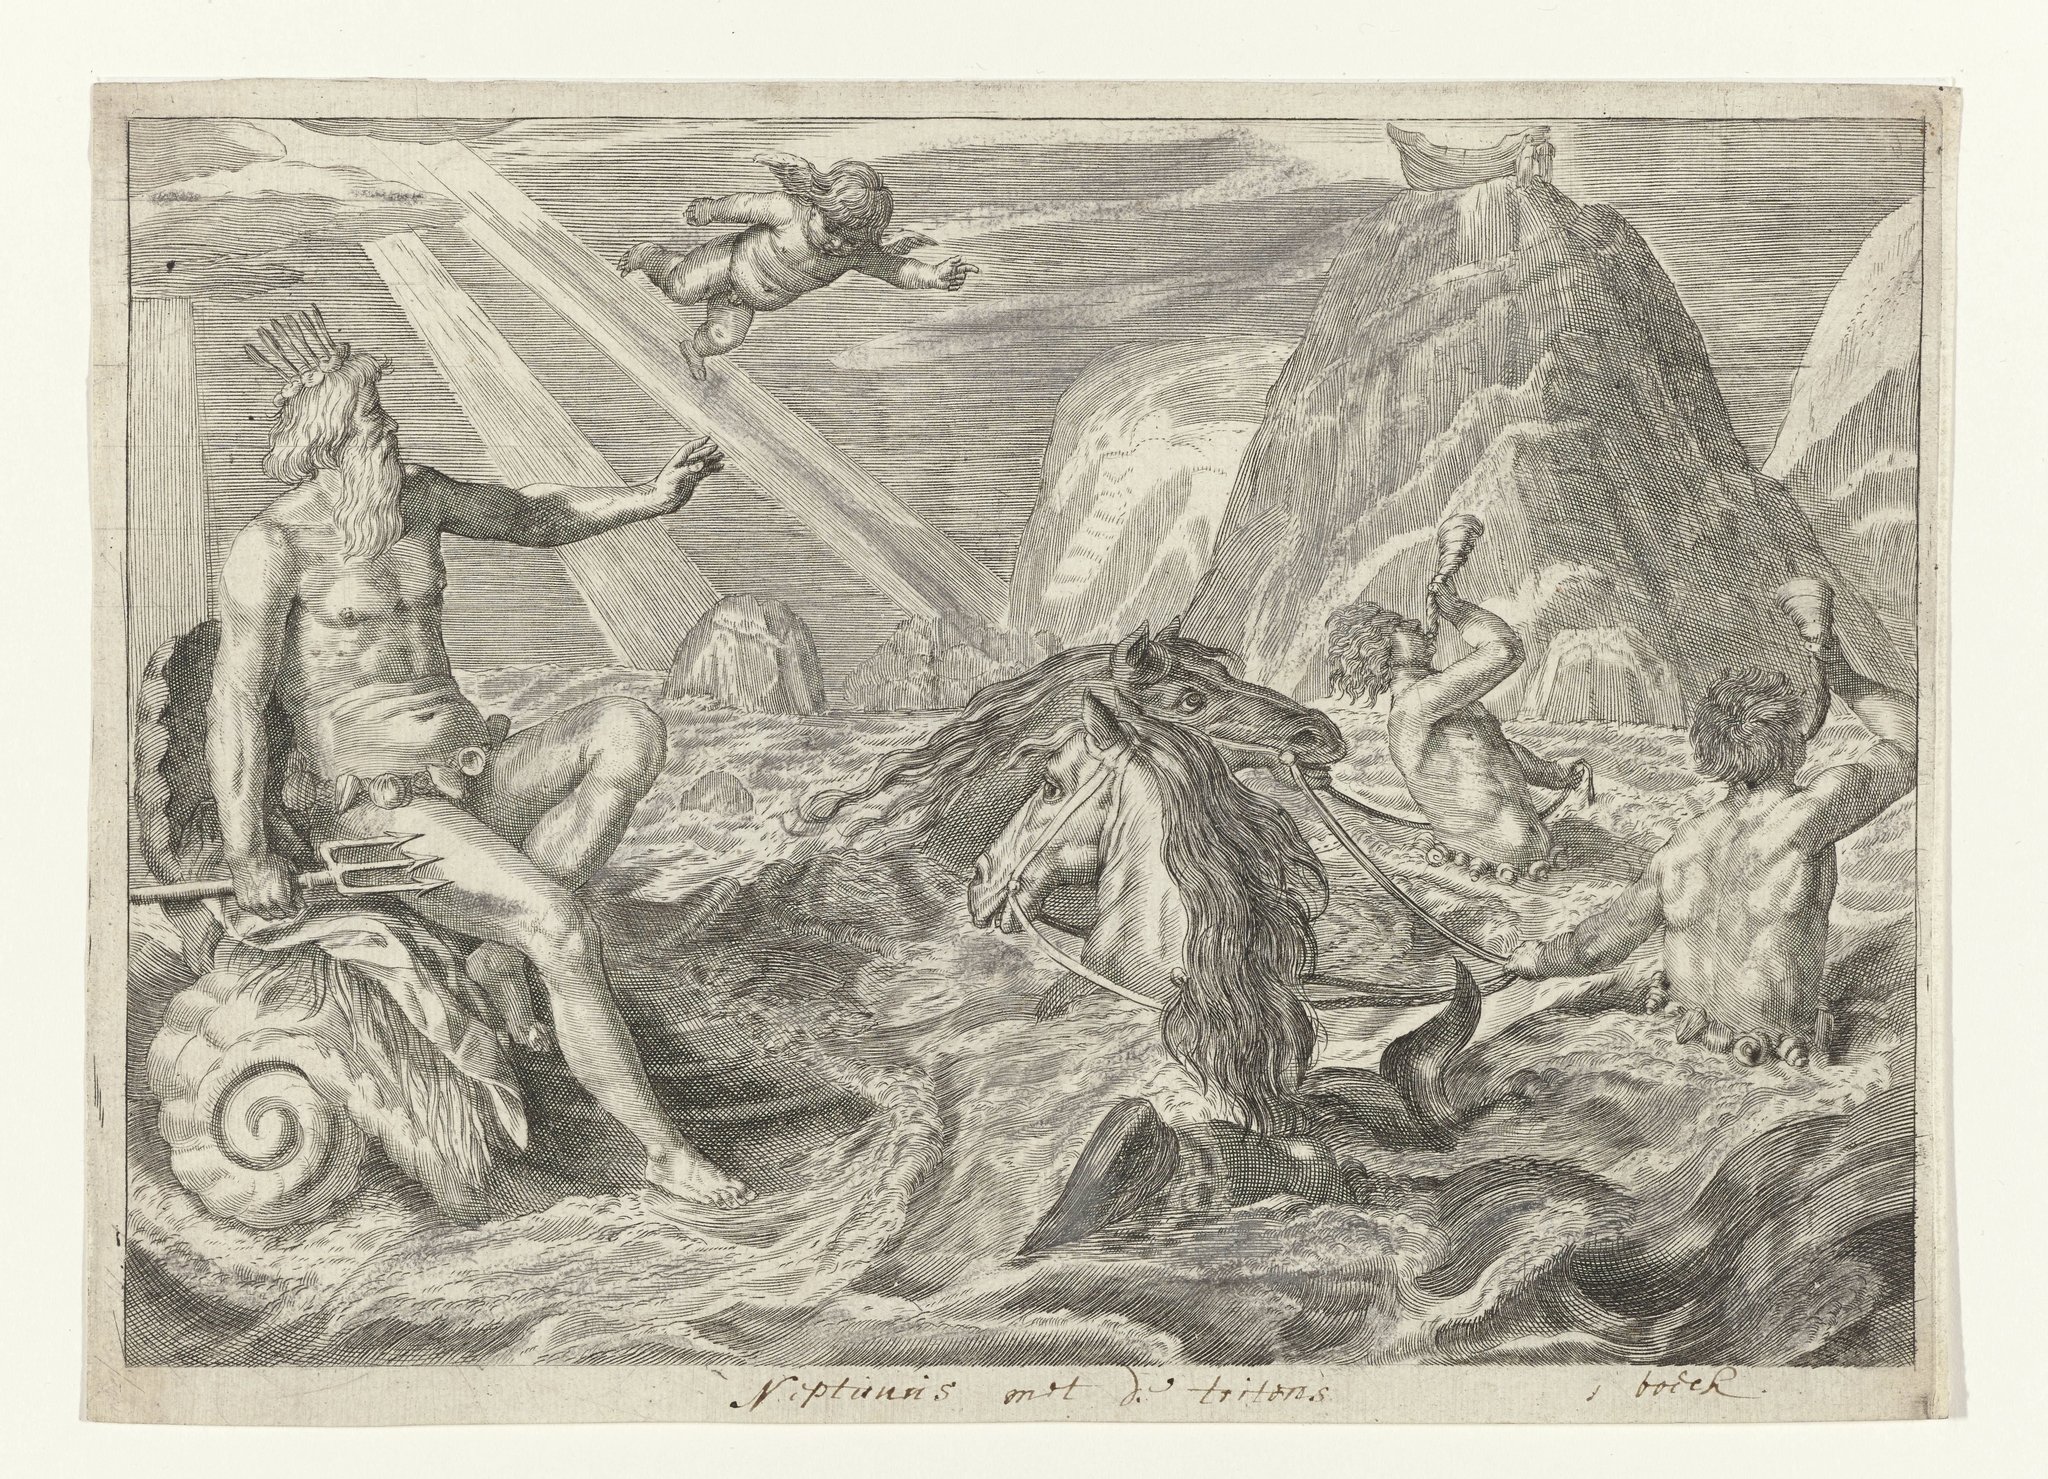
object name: print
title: Metamorfosen van Ovidius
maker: crispijn van de passe (ii)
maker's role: draughtsman, print maker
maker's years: 1594-1670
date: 1636-1670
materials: paper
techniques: engraving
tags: sea thiasos, neptune's sea retinue, neptune as lord of the sea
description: De ambitieuze reeks naar ontwerpen van ondermeer Jacob Pynas, Roeland Savery, Pieter Clouwet, Rubens en Rembrandt is nooit voltooid door de De Passes. De reeks werd uiteindelijk in 1677 in boekvorm uitgegeven in Brussel door Piere Du Rayer en Francois Foppes. Als losse prenten is de reeks alleen bekend uit een groep prenten afkomstig uit de collectie Hinloopen (1619-1708) die zich in het Rijksprentenkabinet bevindt. Deze groep is uitgebreid beschreven door Jan van der Waals in zijn Hinloopen-catalogus (zie: ''Een onbekende editie van een serie Ovidius-illustraties'' in De prentschat van Michiel Hinloopen, 1988, p. 79-102.). De ontdekking van een tweede groep afdrukken van de reeks, afkomstig uit de werkplaats van Crispijn de Passe de Jonge, biedt een belangrijke aanvulling op de Hinloopen-groep. Sommige afdrukken tonen de prenten in onvoltooide staat en zijn voorzien van verbeteringen en toevoegingen in pen en penseel. Bovendien zijn alle prenten voorzien van 17de-eeuwse opschriften die het in een aantal gevallen mogelijk maakt de ontwerpers van de voorstellingen nader te identificeren. Op grond van de aangetroffen watermerken kunnen de afdrukken worden gedateerd omstreeks 1652-1653.